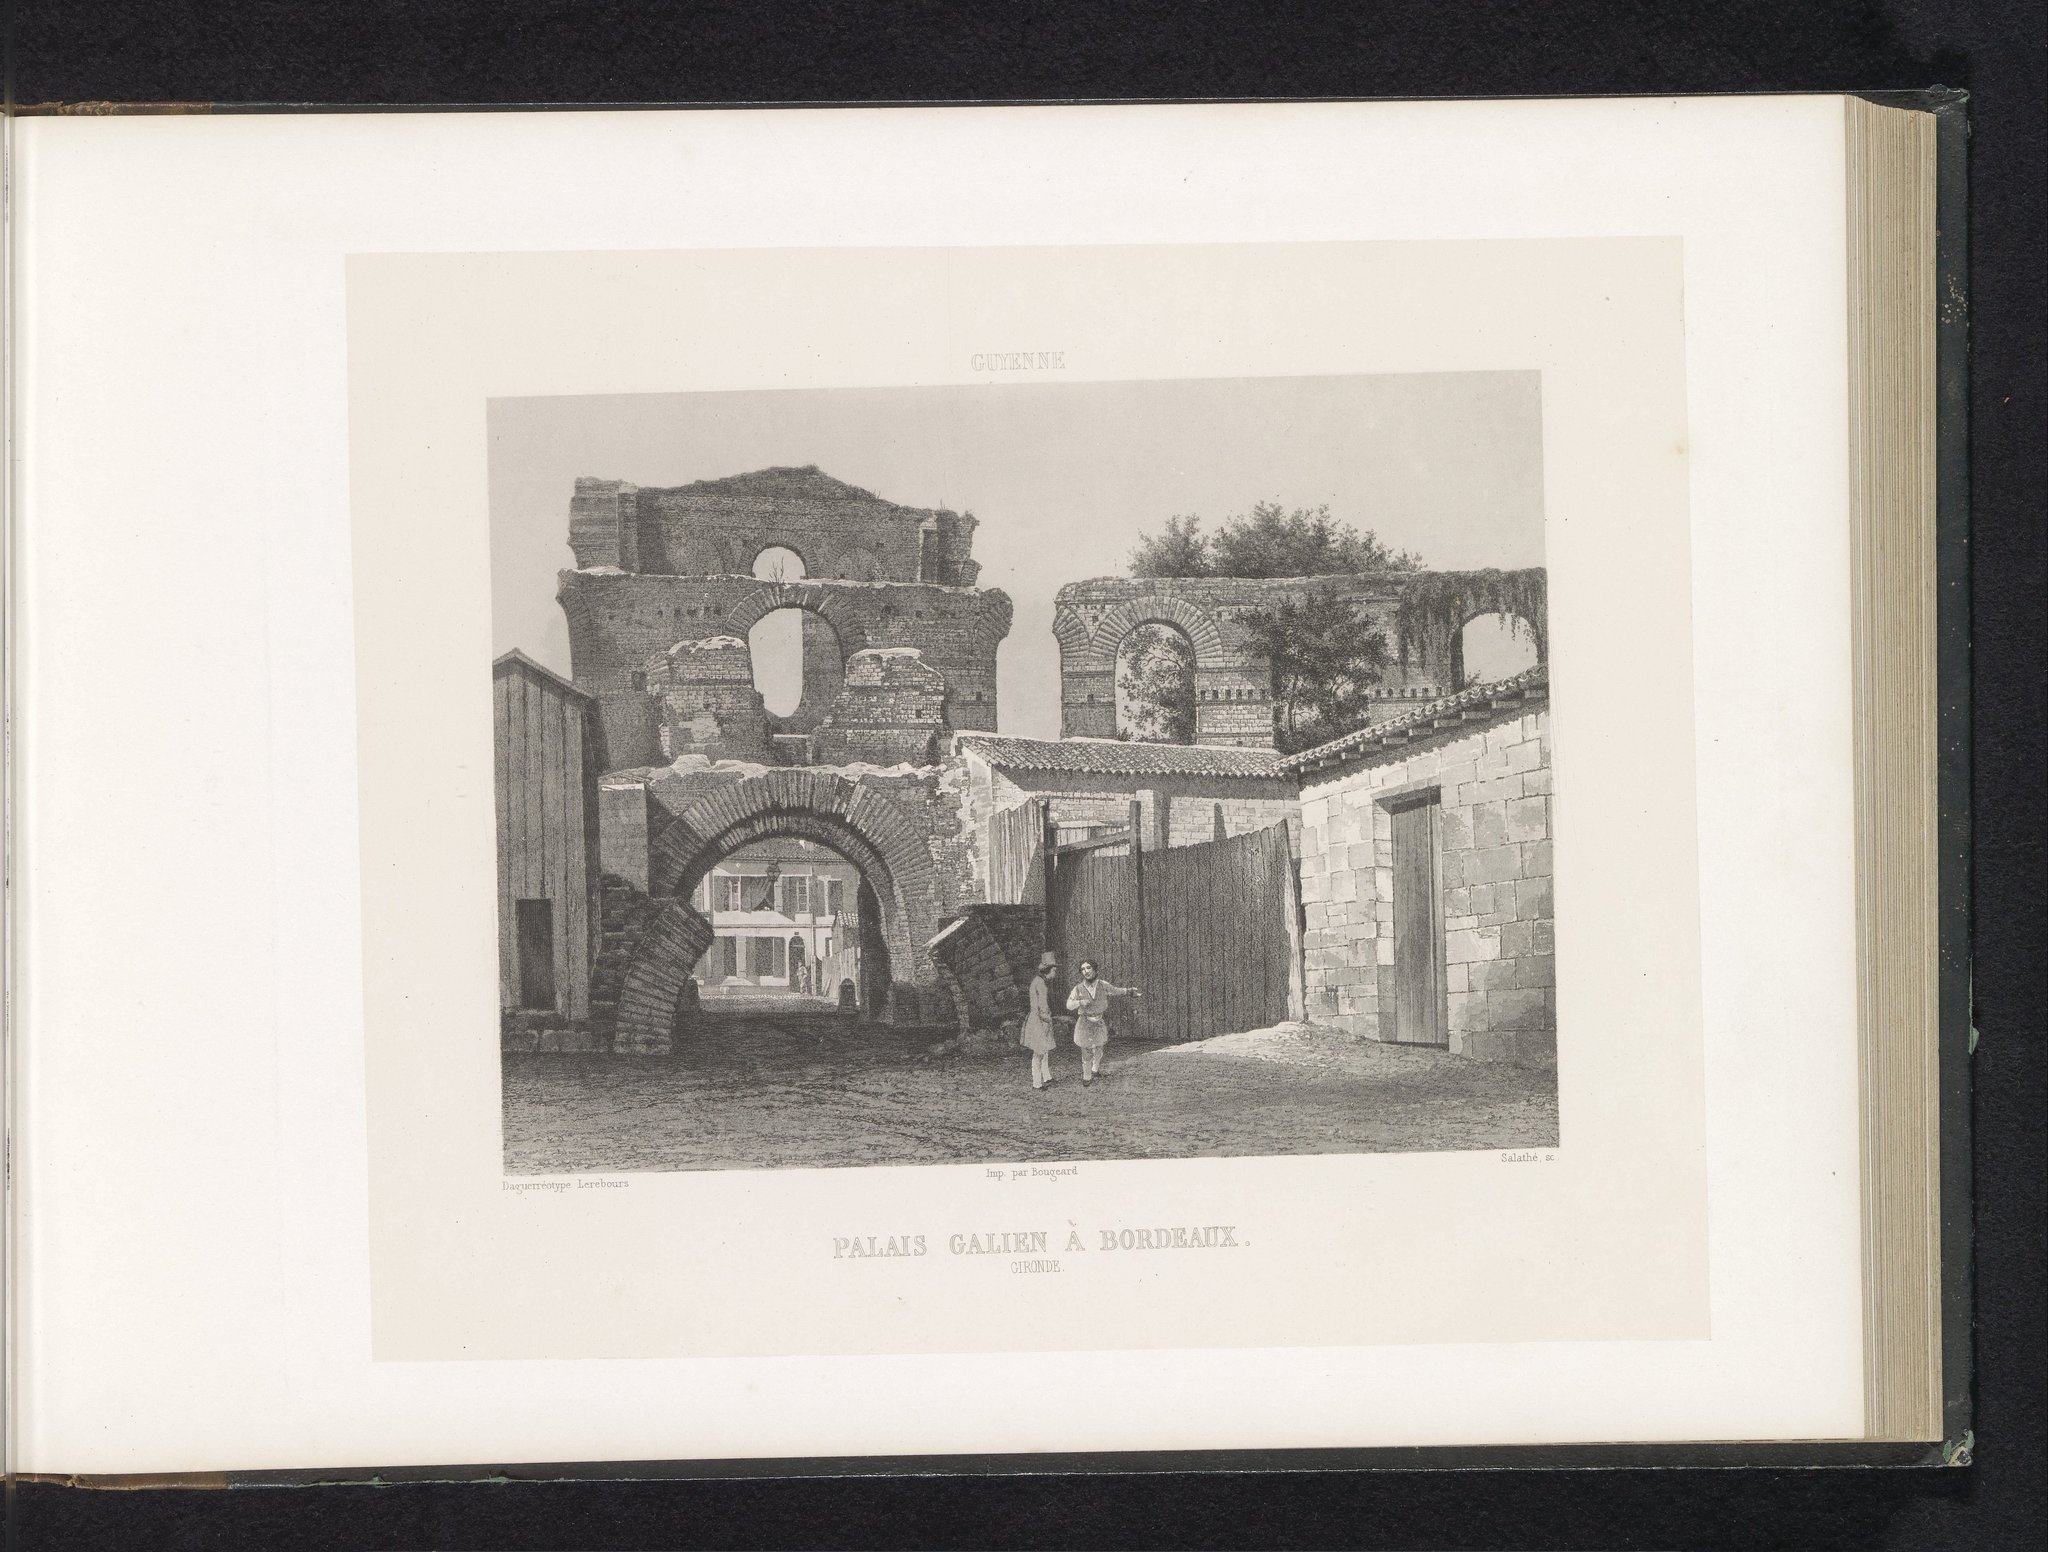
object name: page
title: Palais Galien à Bordeaux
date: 1839-1841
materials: paper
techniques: aquatint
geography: paris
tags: ruin of a building ~ architecture, theatre (building)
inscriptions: inscription: ‘Hr. Bossance Quai Voltaire 11’, inscription: ‘N.P. Lerebours Place du Pont Neuf 15’, inscription: ‘Rittner & Goupil Boulevd Montmartre 15’